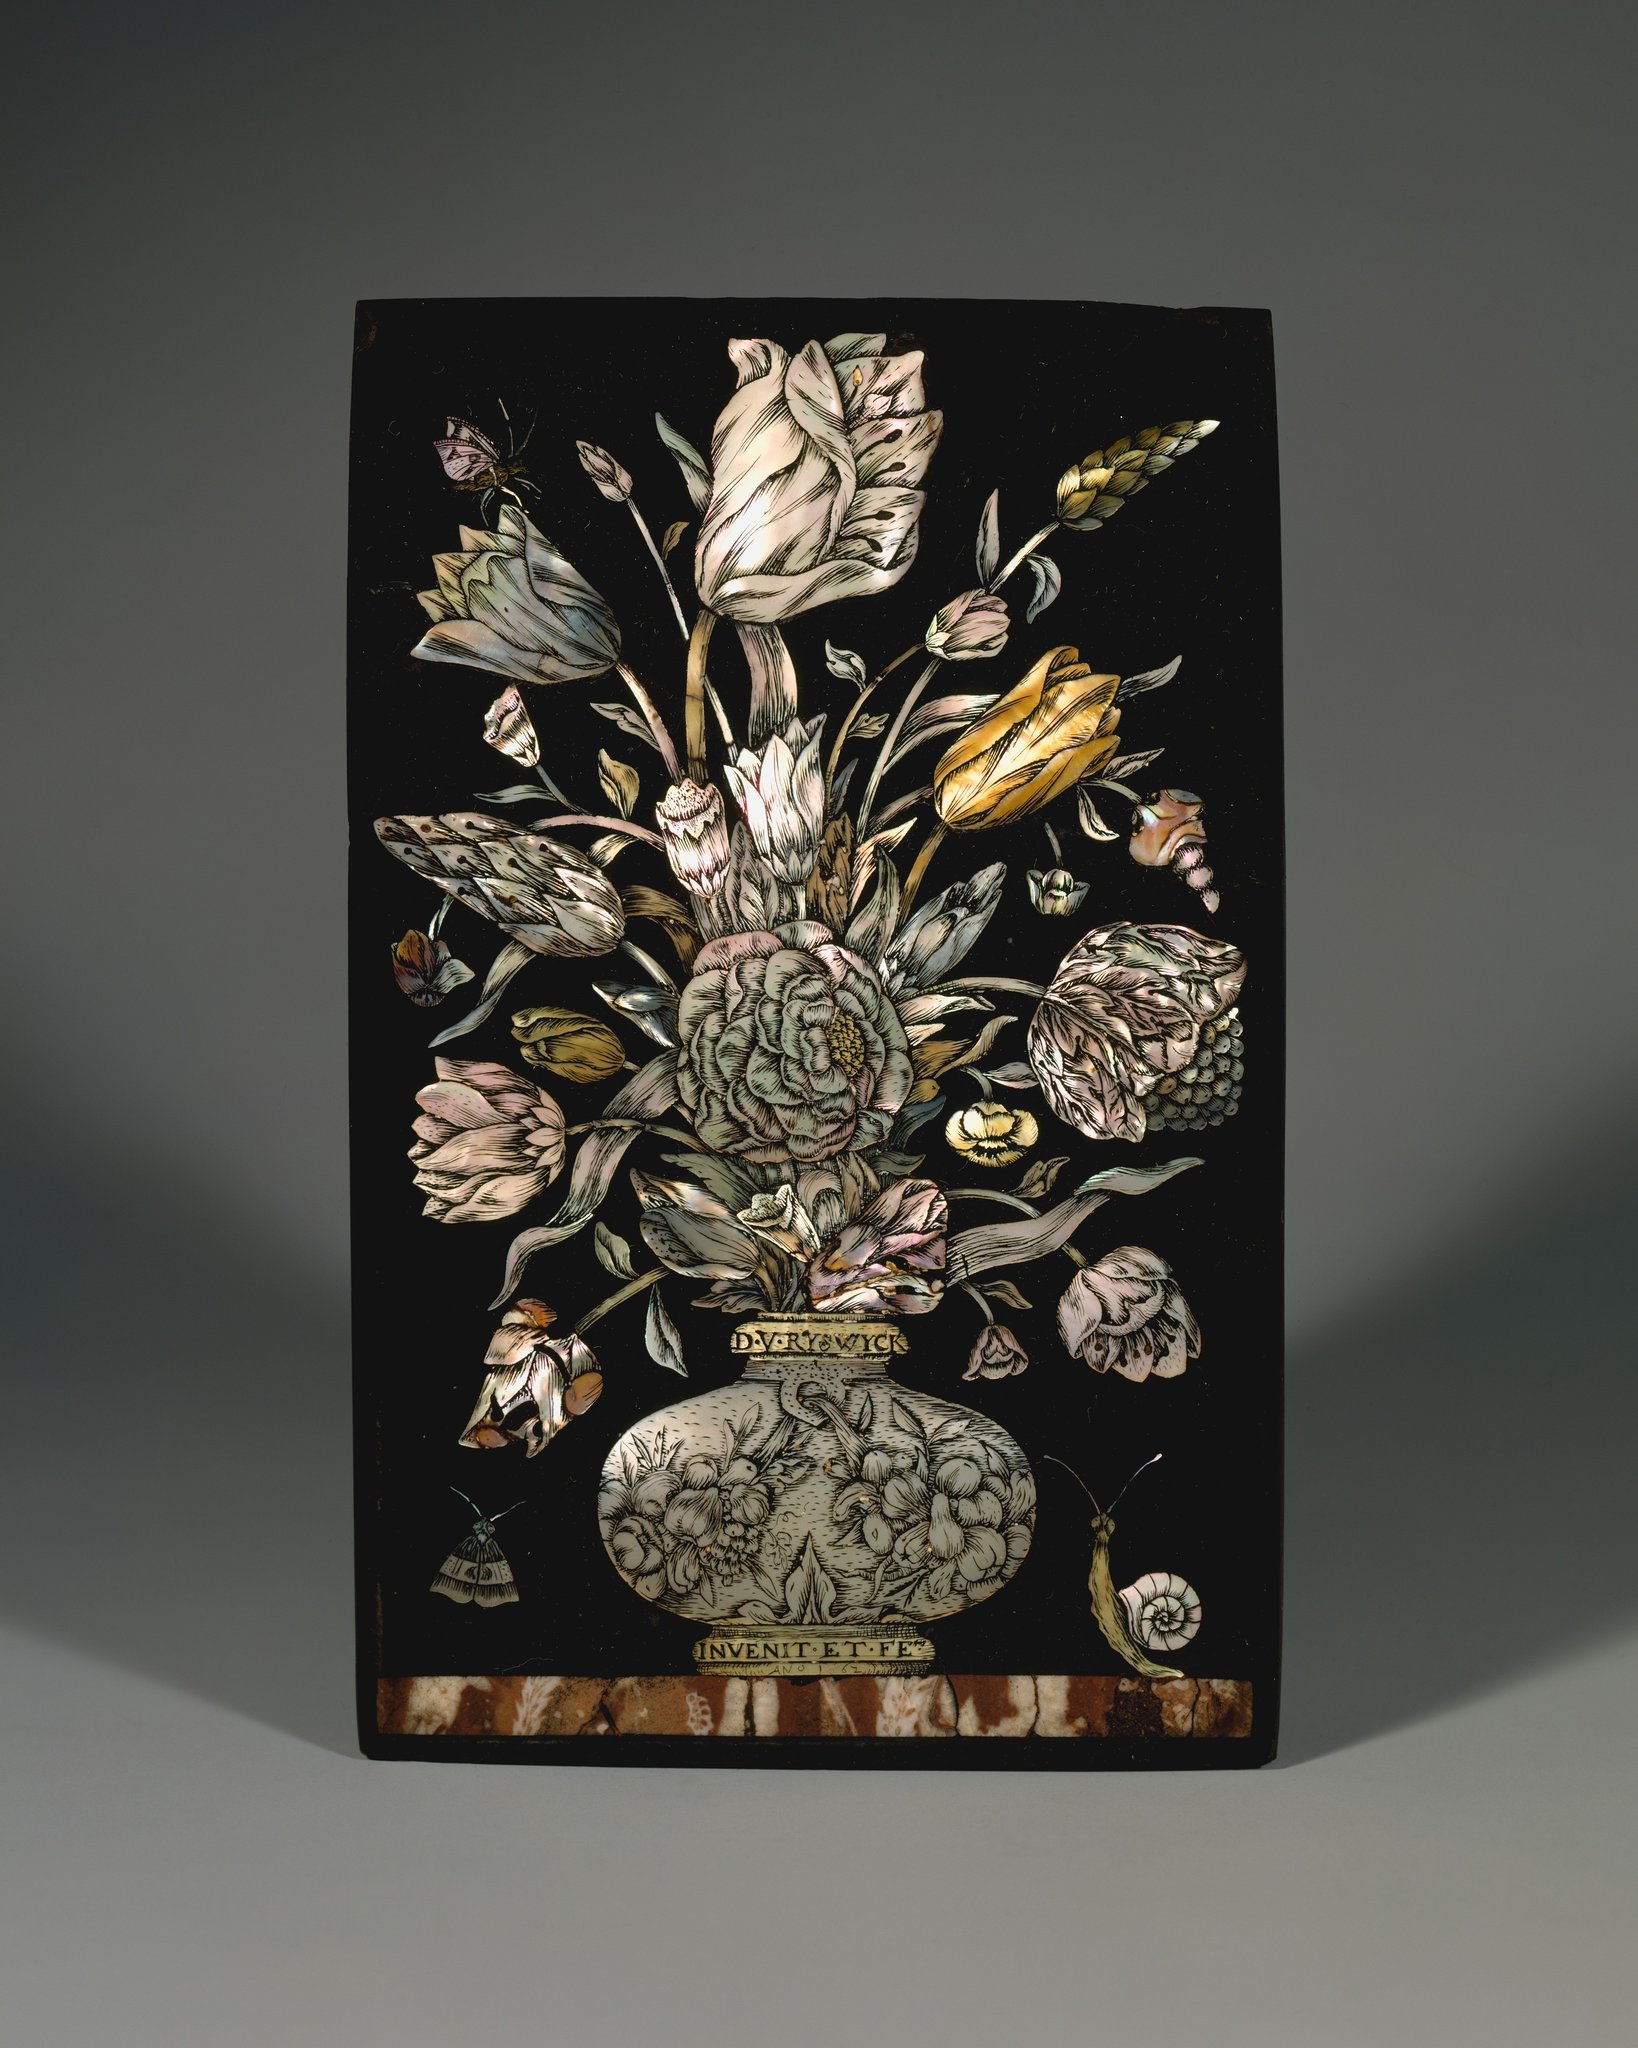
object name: plaque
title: Floral still life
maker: dirck van rijswijck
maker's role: artist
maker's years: 1596-1679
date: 1662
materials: wood, marble, mother of pearl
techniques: engraving, inlay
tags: flowers,still life